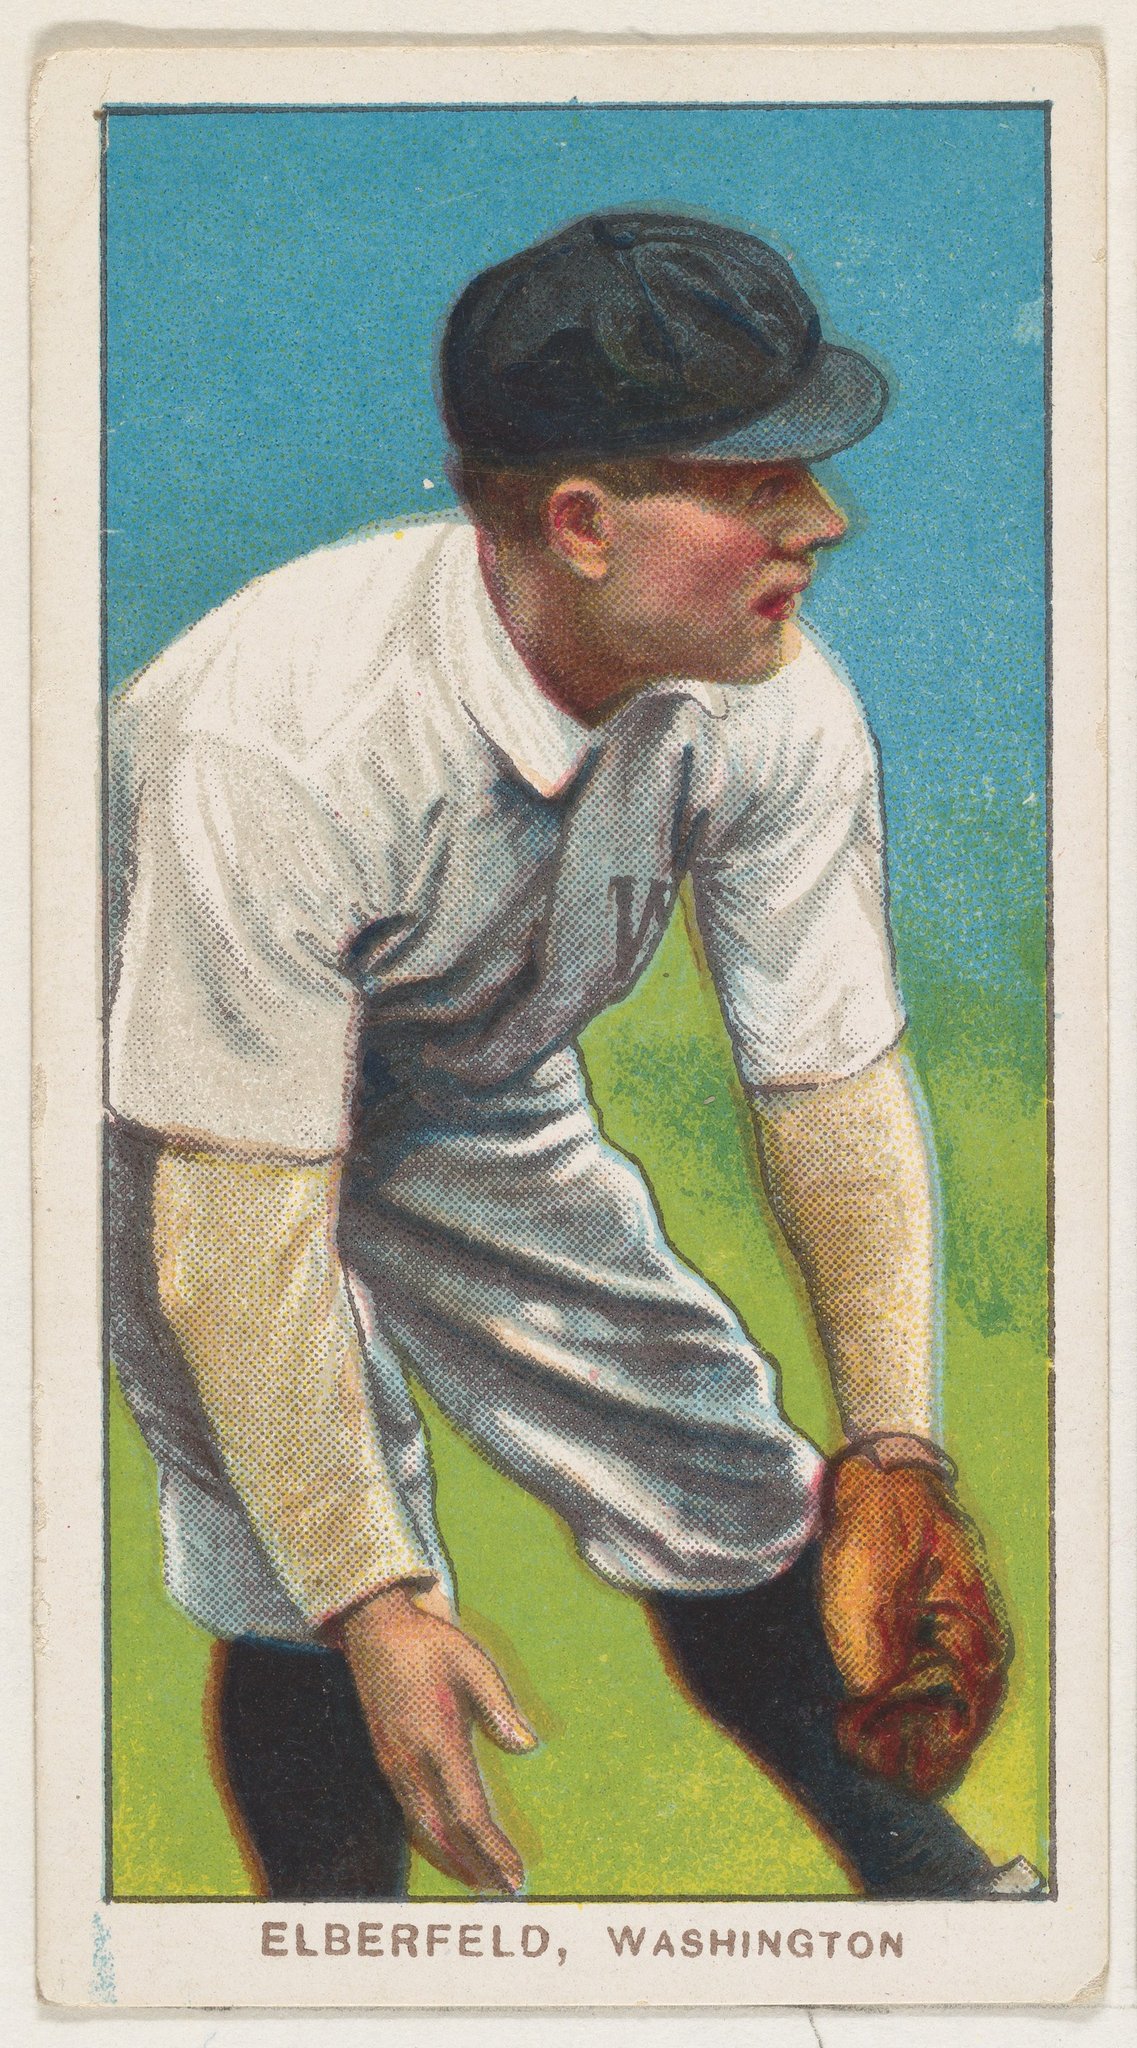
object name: baseball card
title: Elberfeld, Washington, American League, from the White Border series (T206) for the American Tobacco Company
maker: american tobacco company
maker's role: publisher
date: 1909-1911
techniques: lithography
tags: men,baseball,athletes